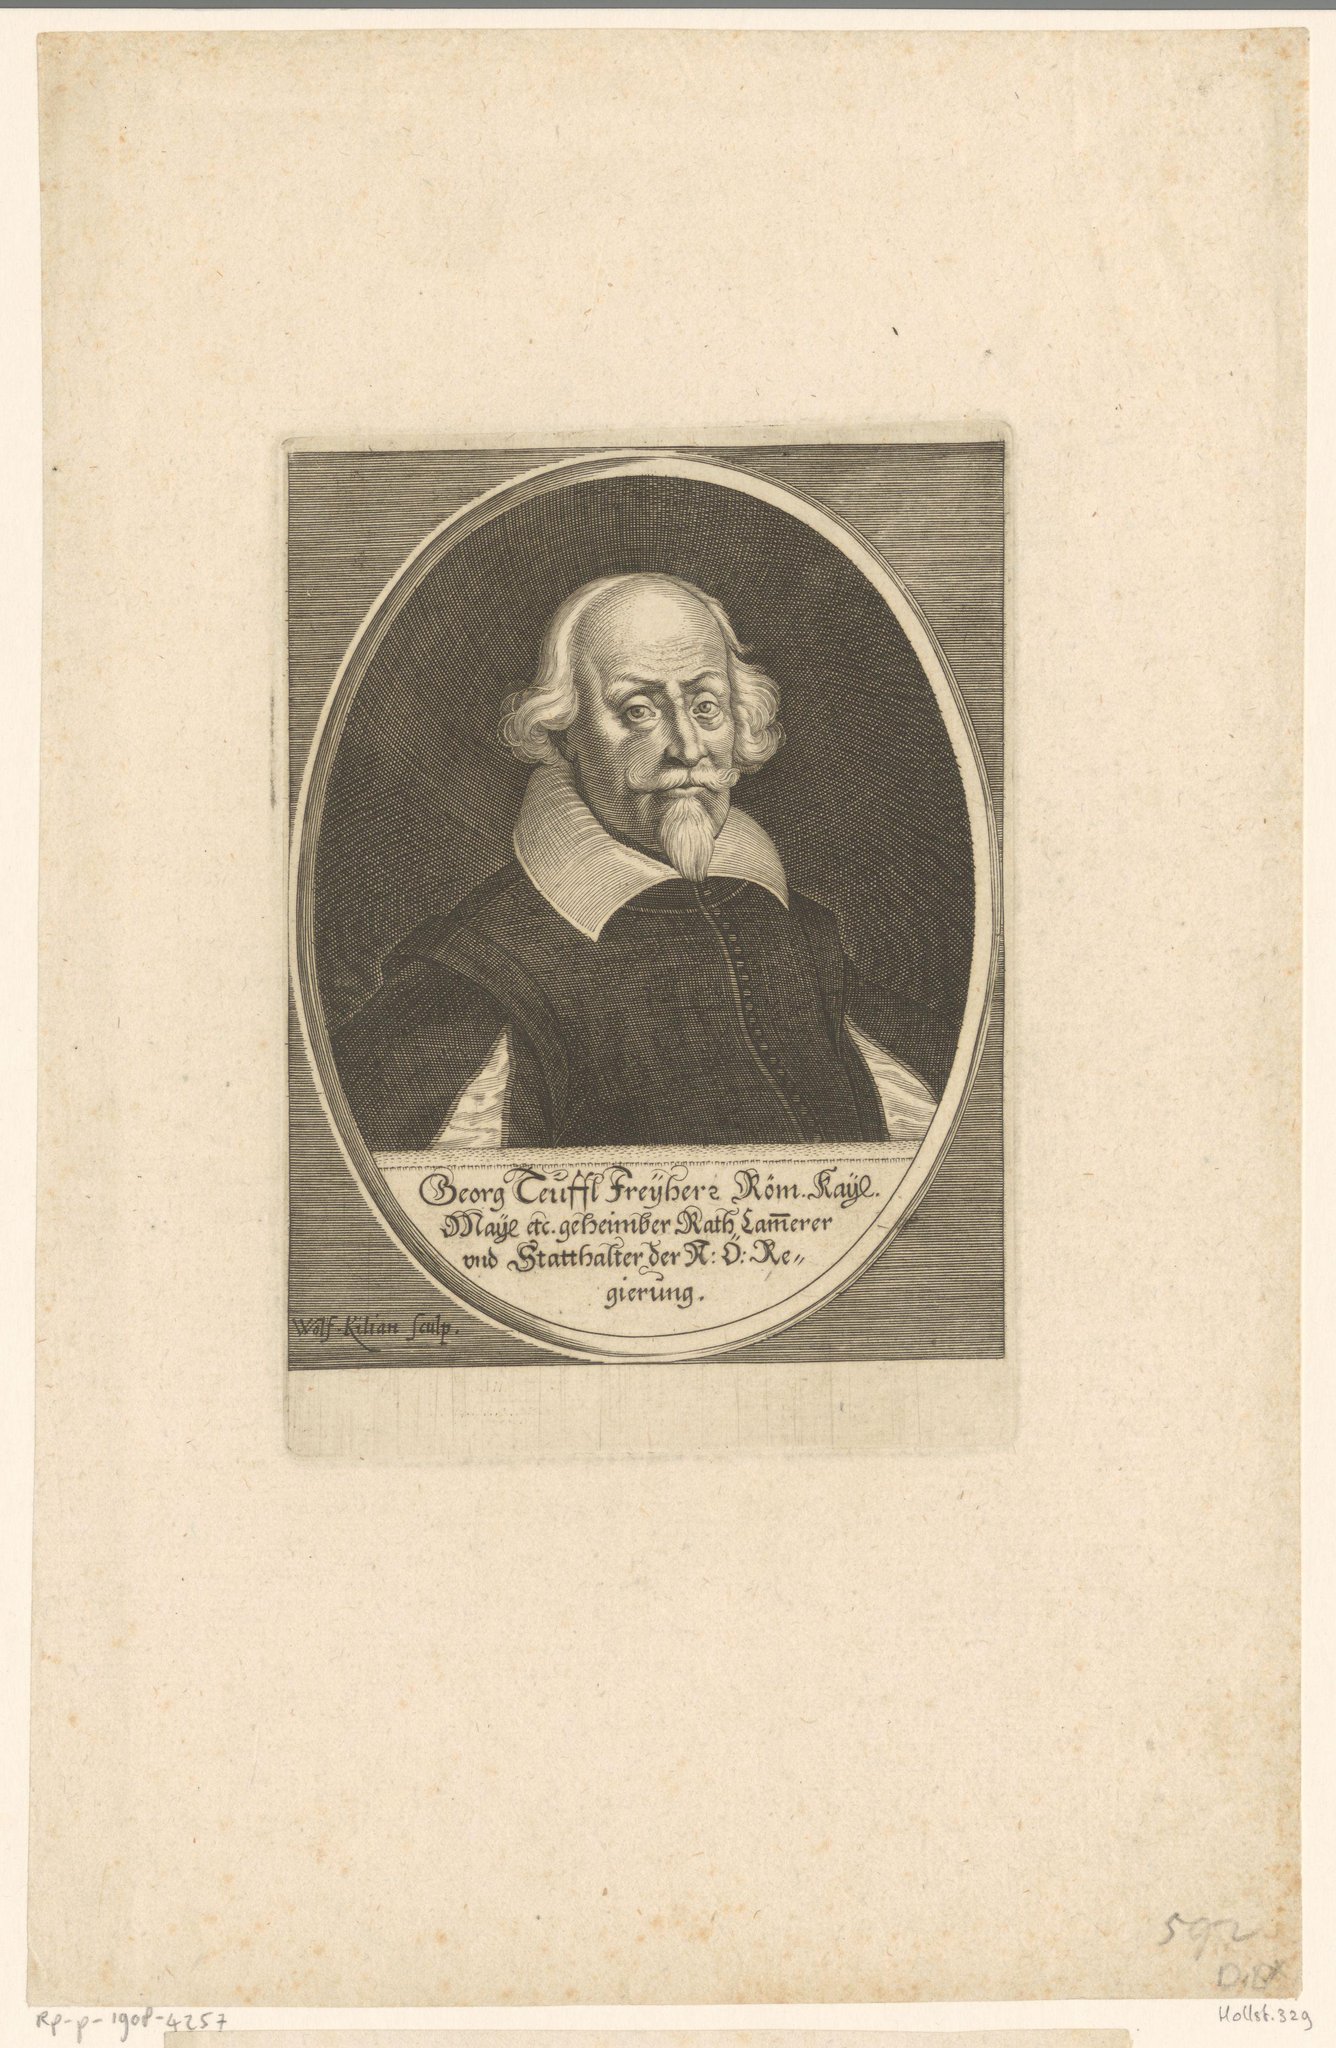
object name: print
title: Portret van Georg Teuffel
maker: wolfgang kilian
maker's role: print maker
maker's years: 1581-1662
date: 1591-1662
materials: paper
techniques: engraving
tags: city council, commander-in-chief, general, marshal, historical persons, counsellor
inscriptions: collector's mark: Lugt 2228